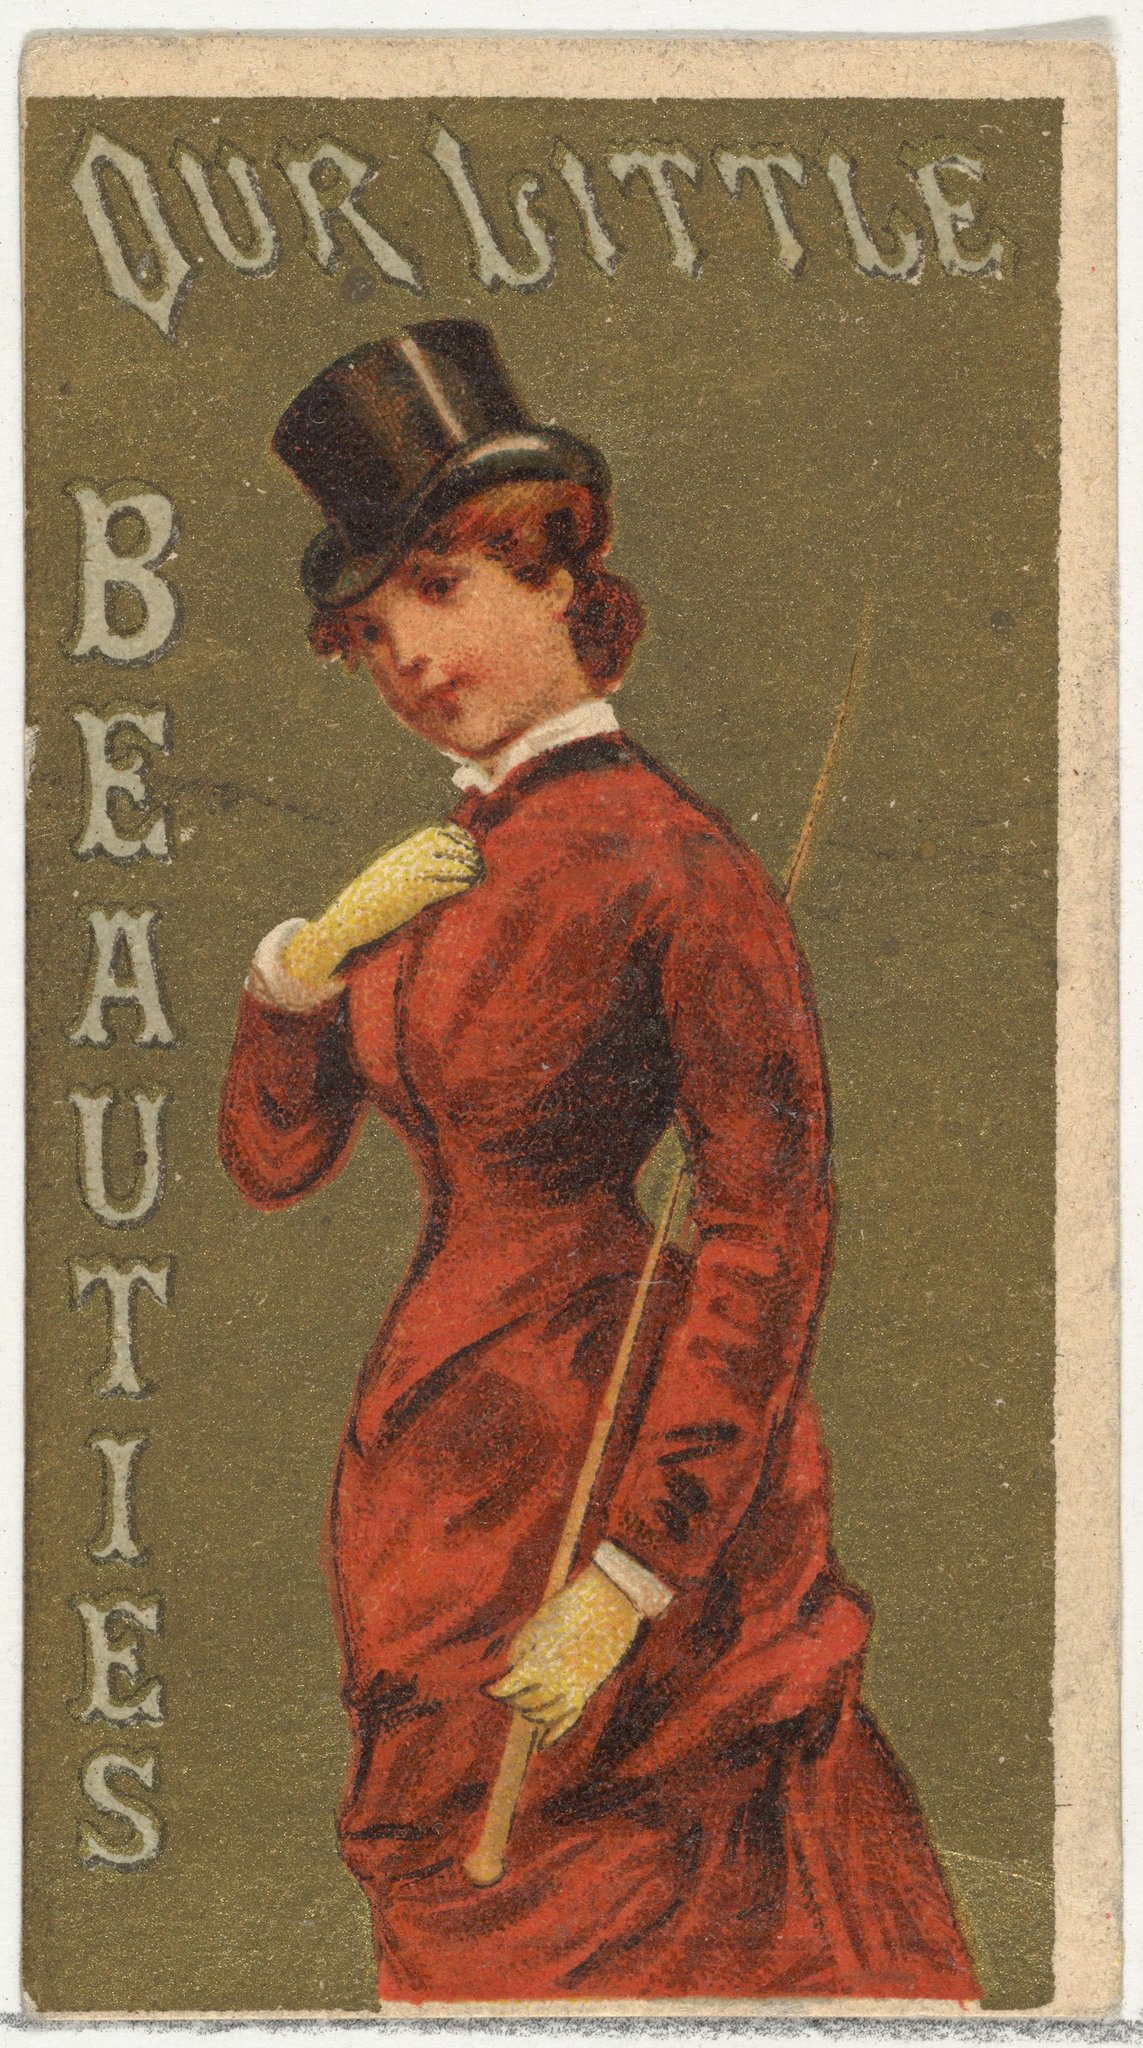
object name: print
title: From the Girls and Children series (N58) promoting Our Little Beauties Cigarettes for Allen & Ginter brand tobacco products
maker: allen & ginter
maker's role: publisher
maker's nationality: american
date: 1887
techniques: color lithograph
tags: girls